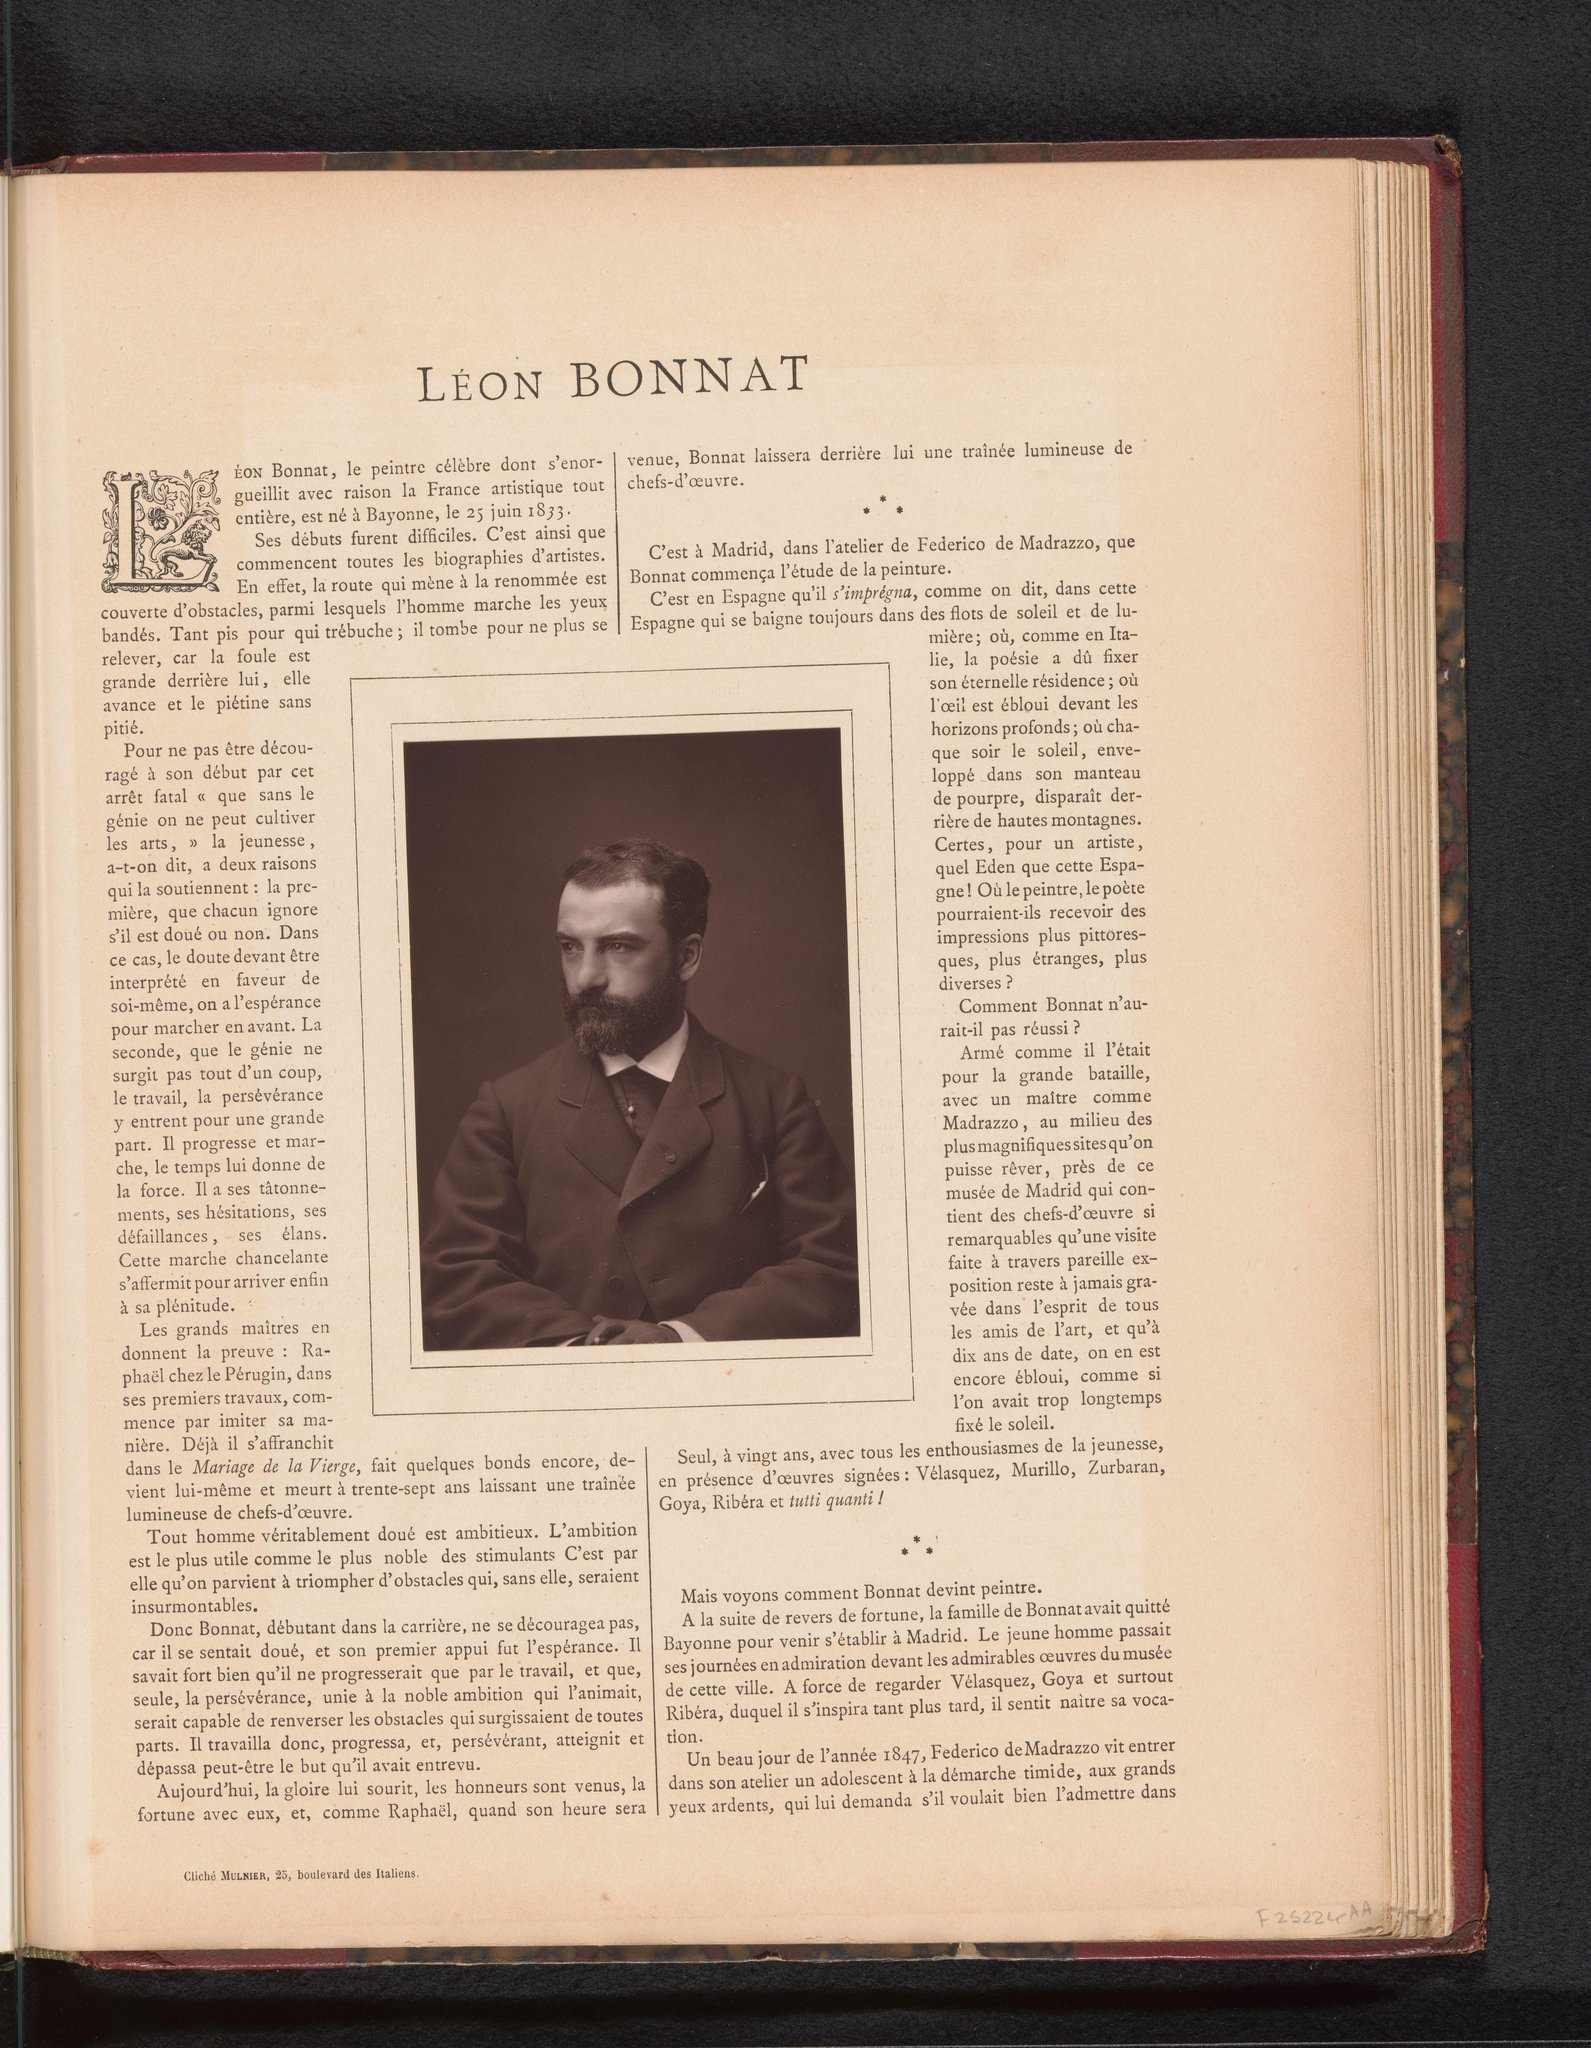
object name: page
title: Portret van Léon Bonnat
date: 1867-1880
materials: paper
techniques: woodburytype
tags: painter, léon bonnat, adult man, historical persons